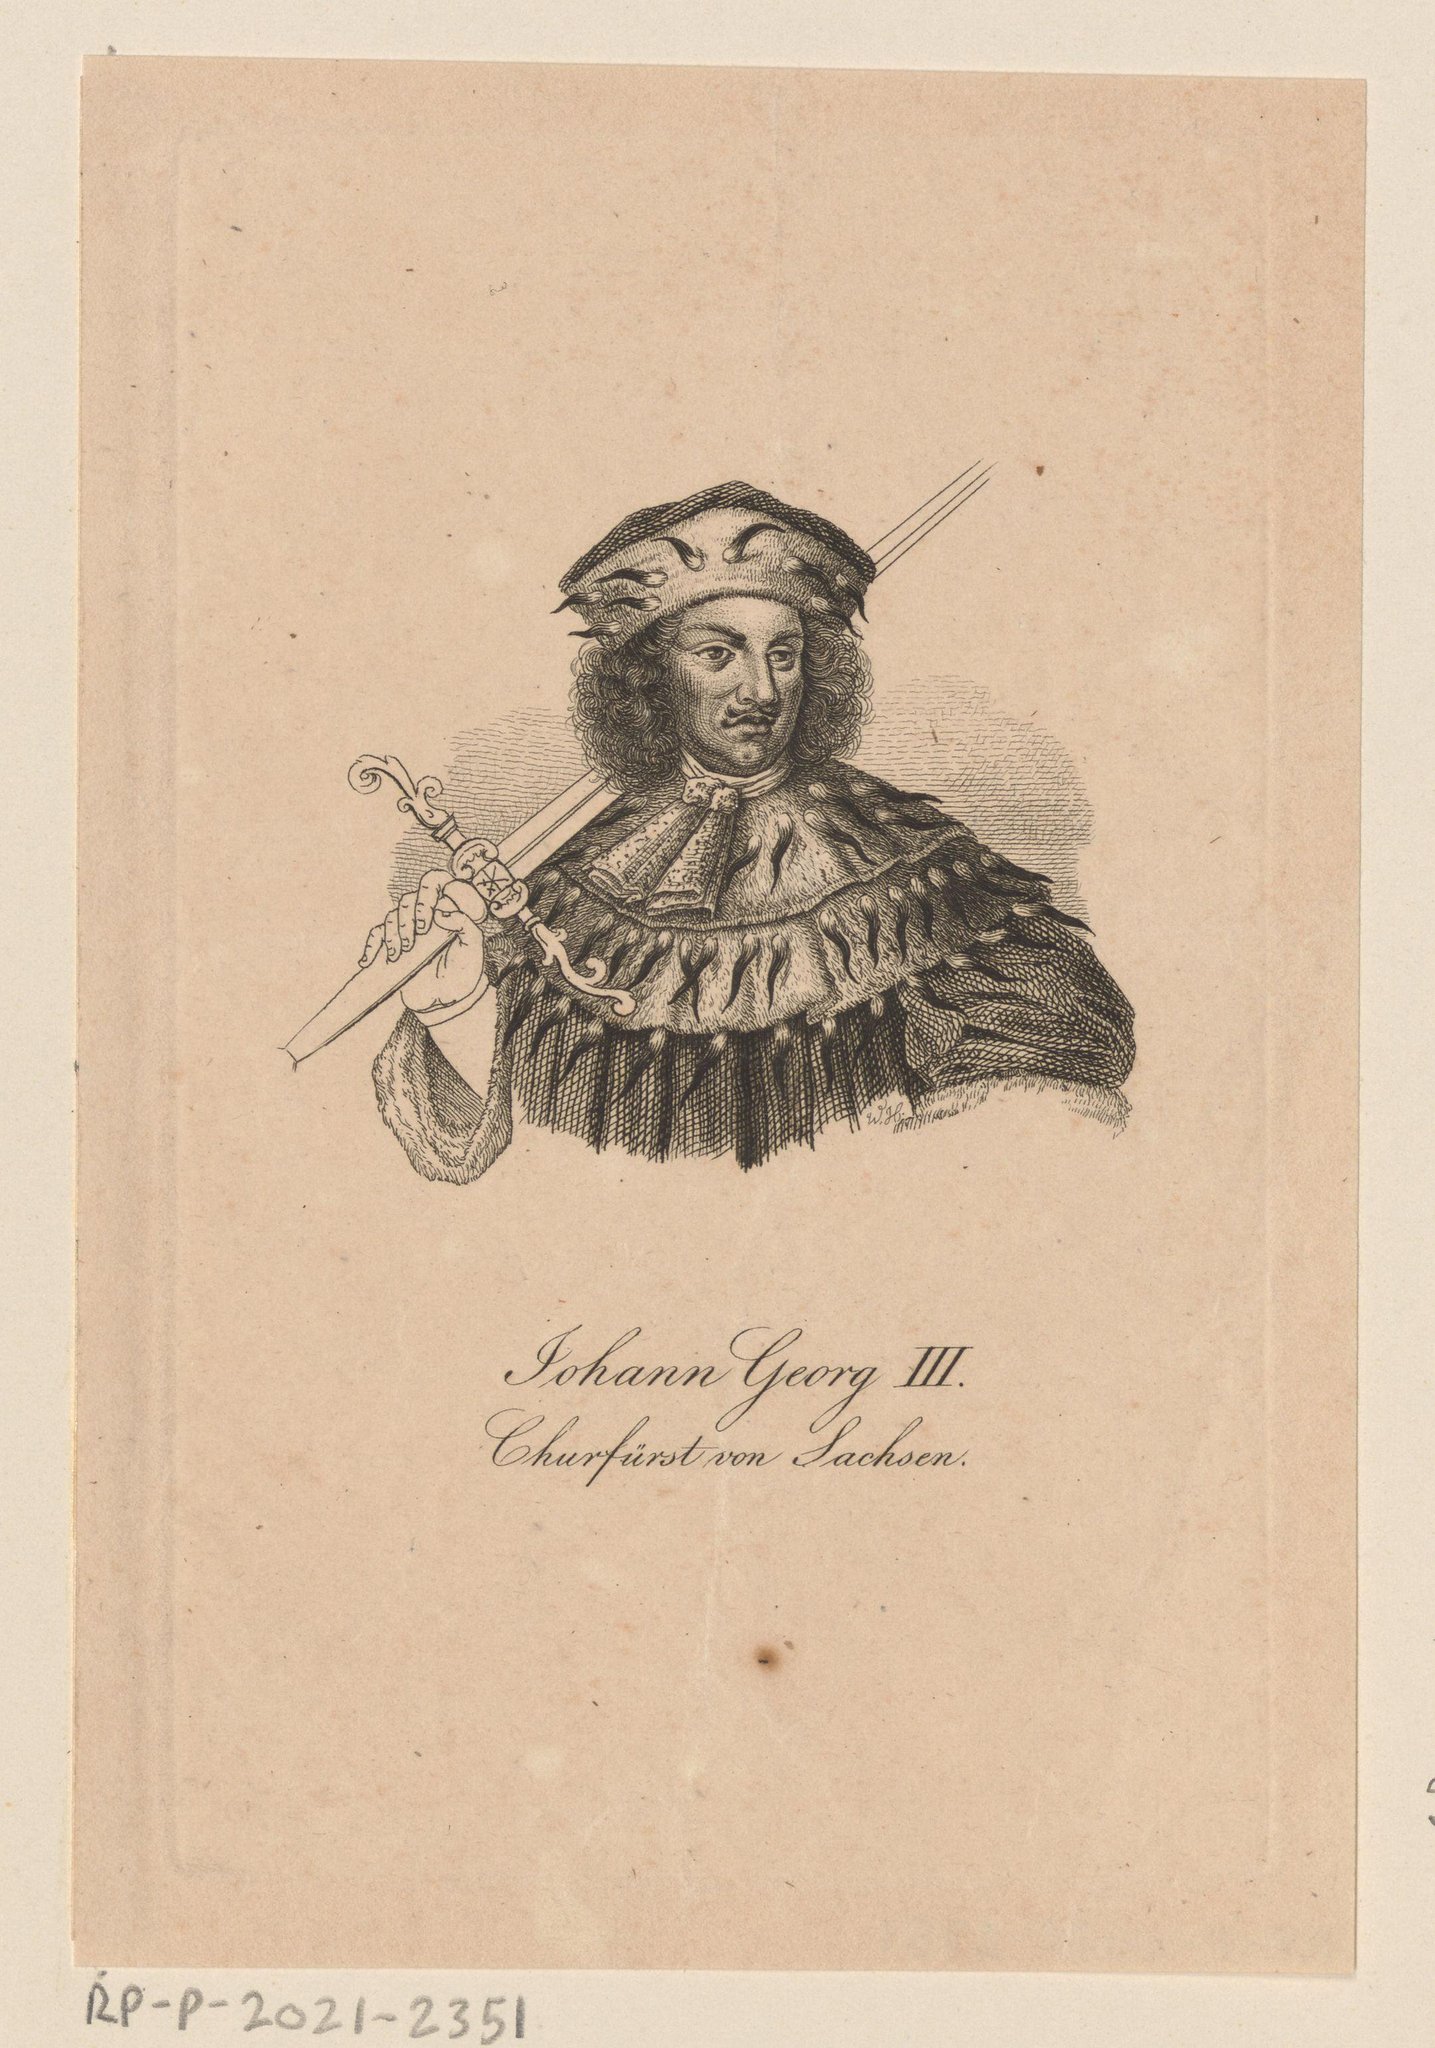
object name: print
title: Portret van Johan Georg III, keurvorst van Saksen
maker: Anonymous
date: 1750-1849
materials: paper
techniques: etching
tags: historical persons, hacking and thrusting weapons: sword, head-gear: hat, ruler, sovereign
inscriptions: monogram: ‘W.H.’